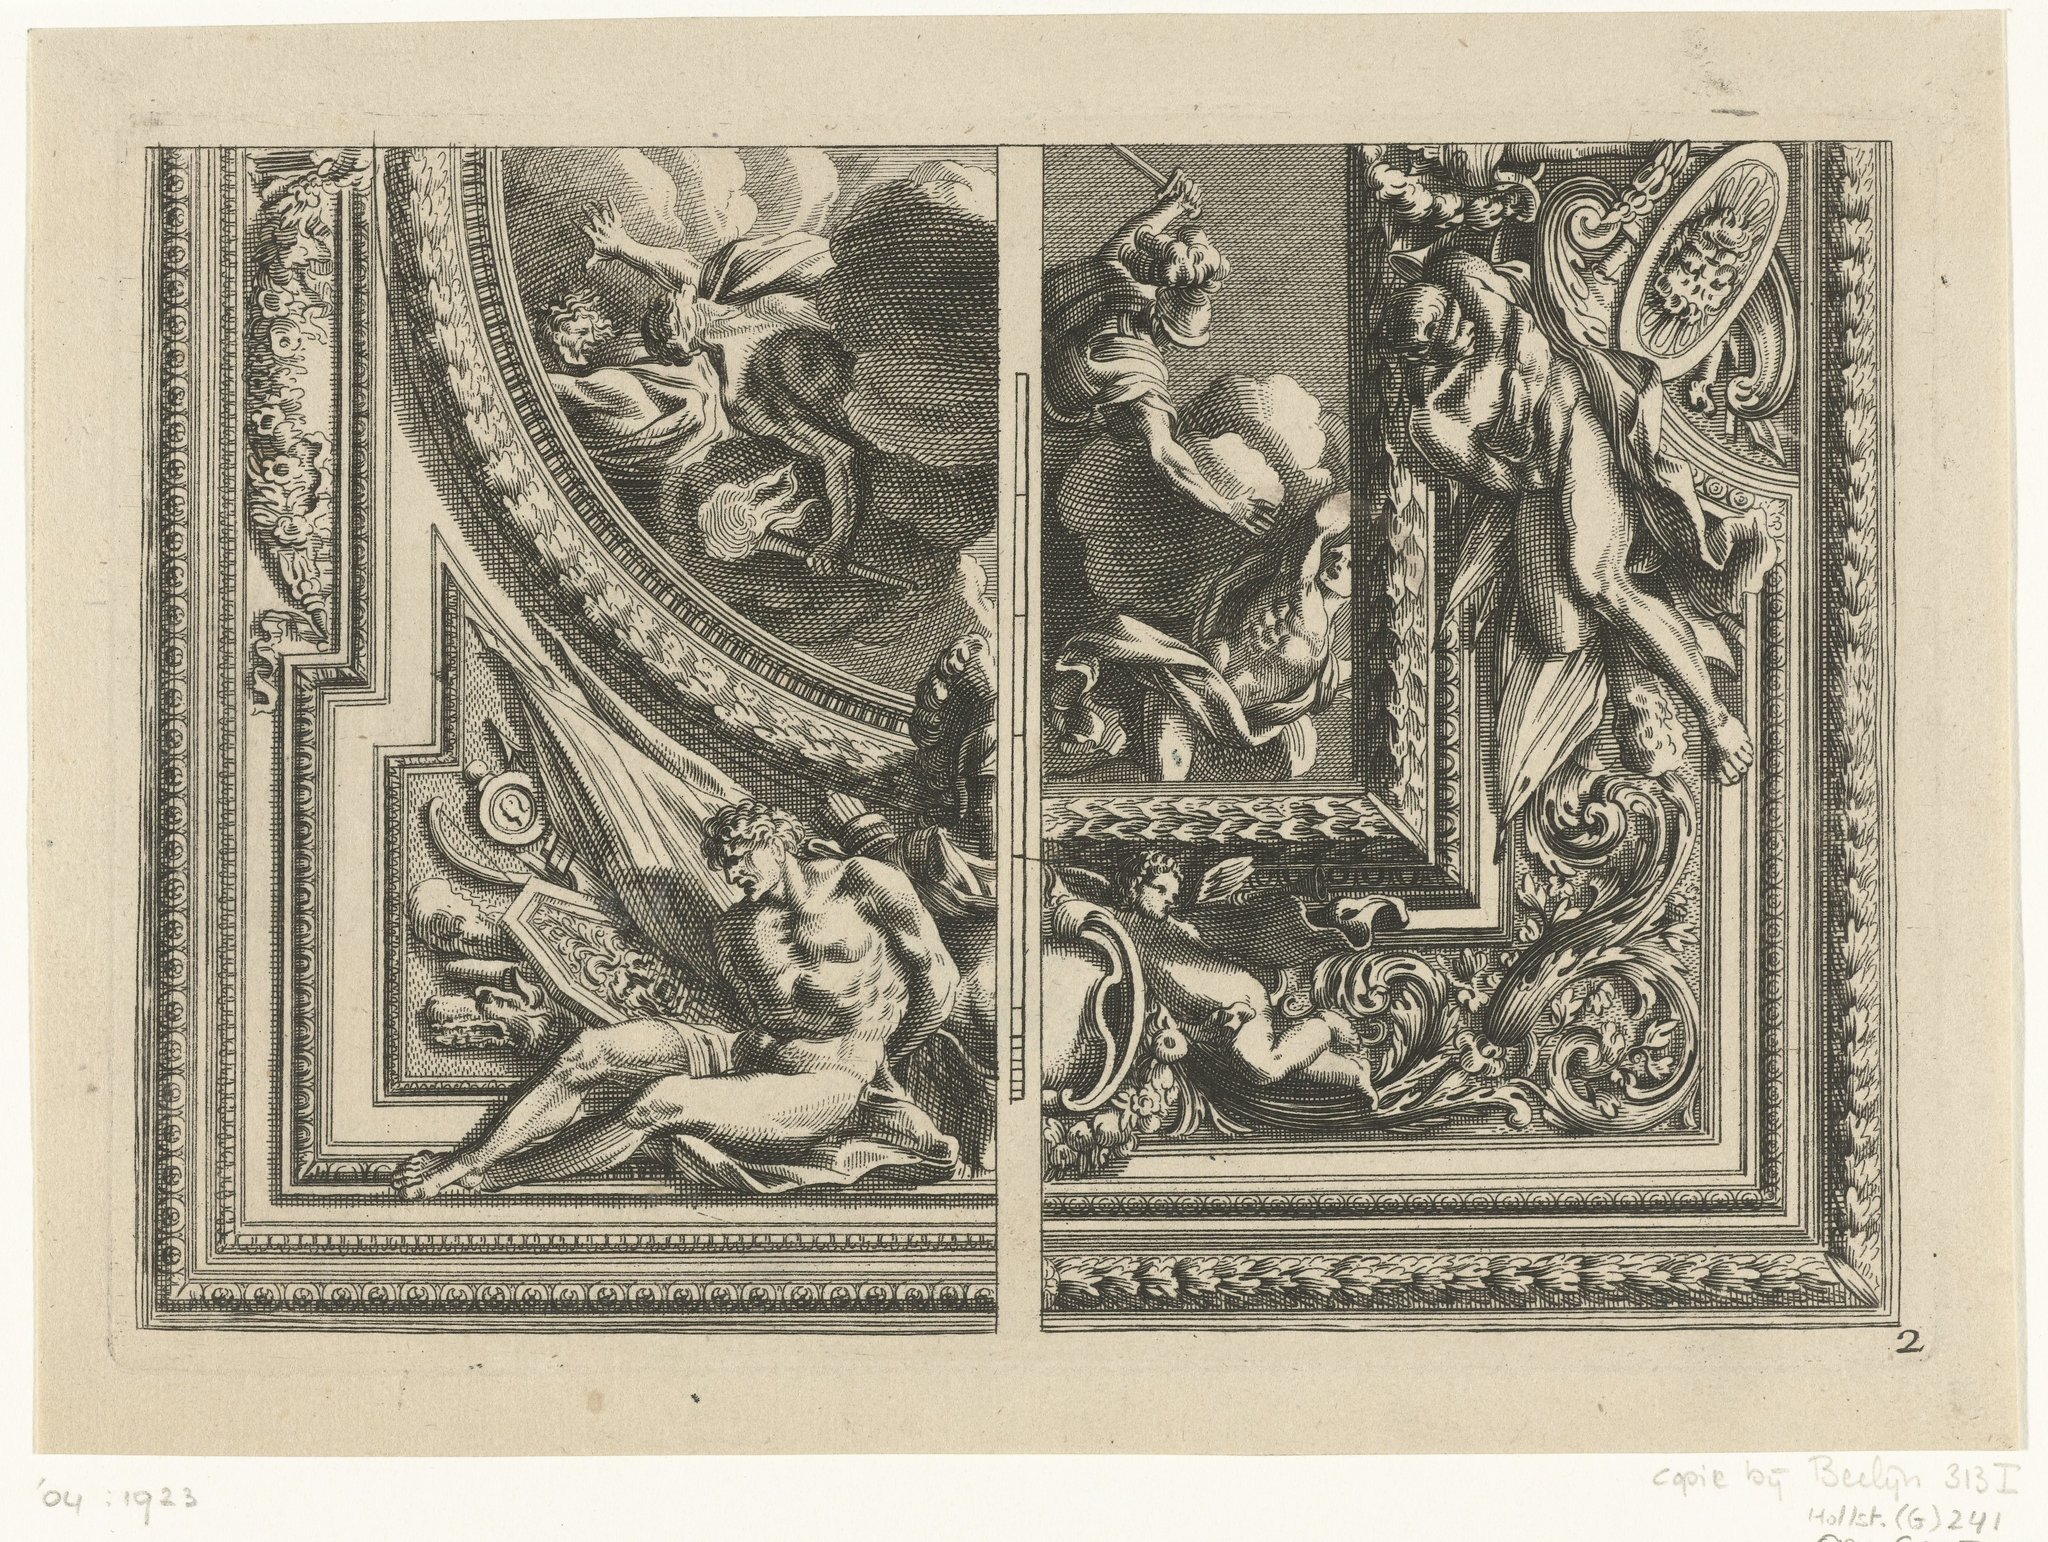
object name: ornament print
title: Twee kwarten van plafonds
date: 1668-1716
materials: paper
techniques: etching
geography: france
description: Twee varianten met watertrofeën en een geketende gevangene.